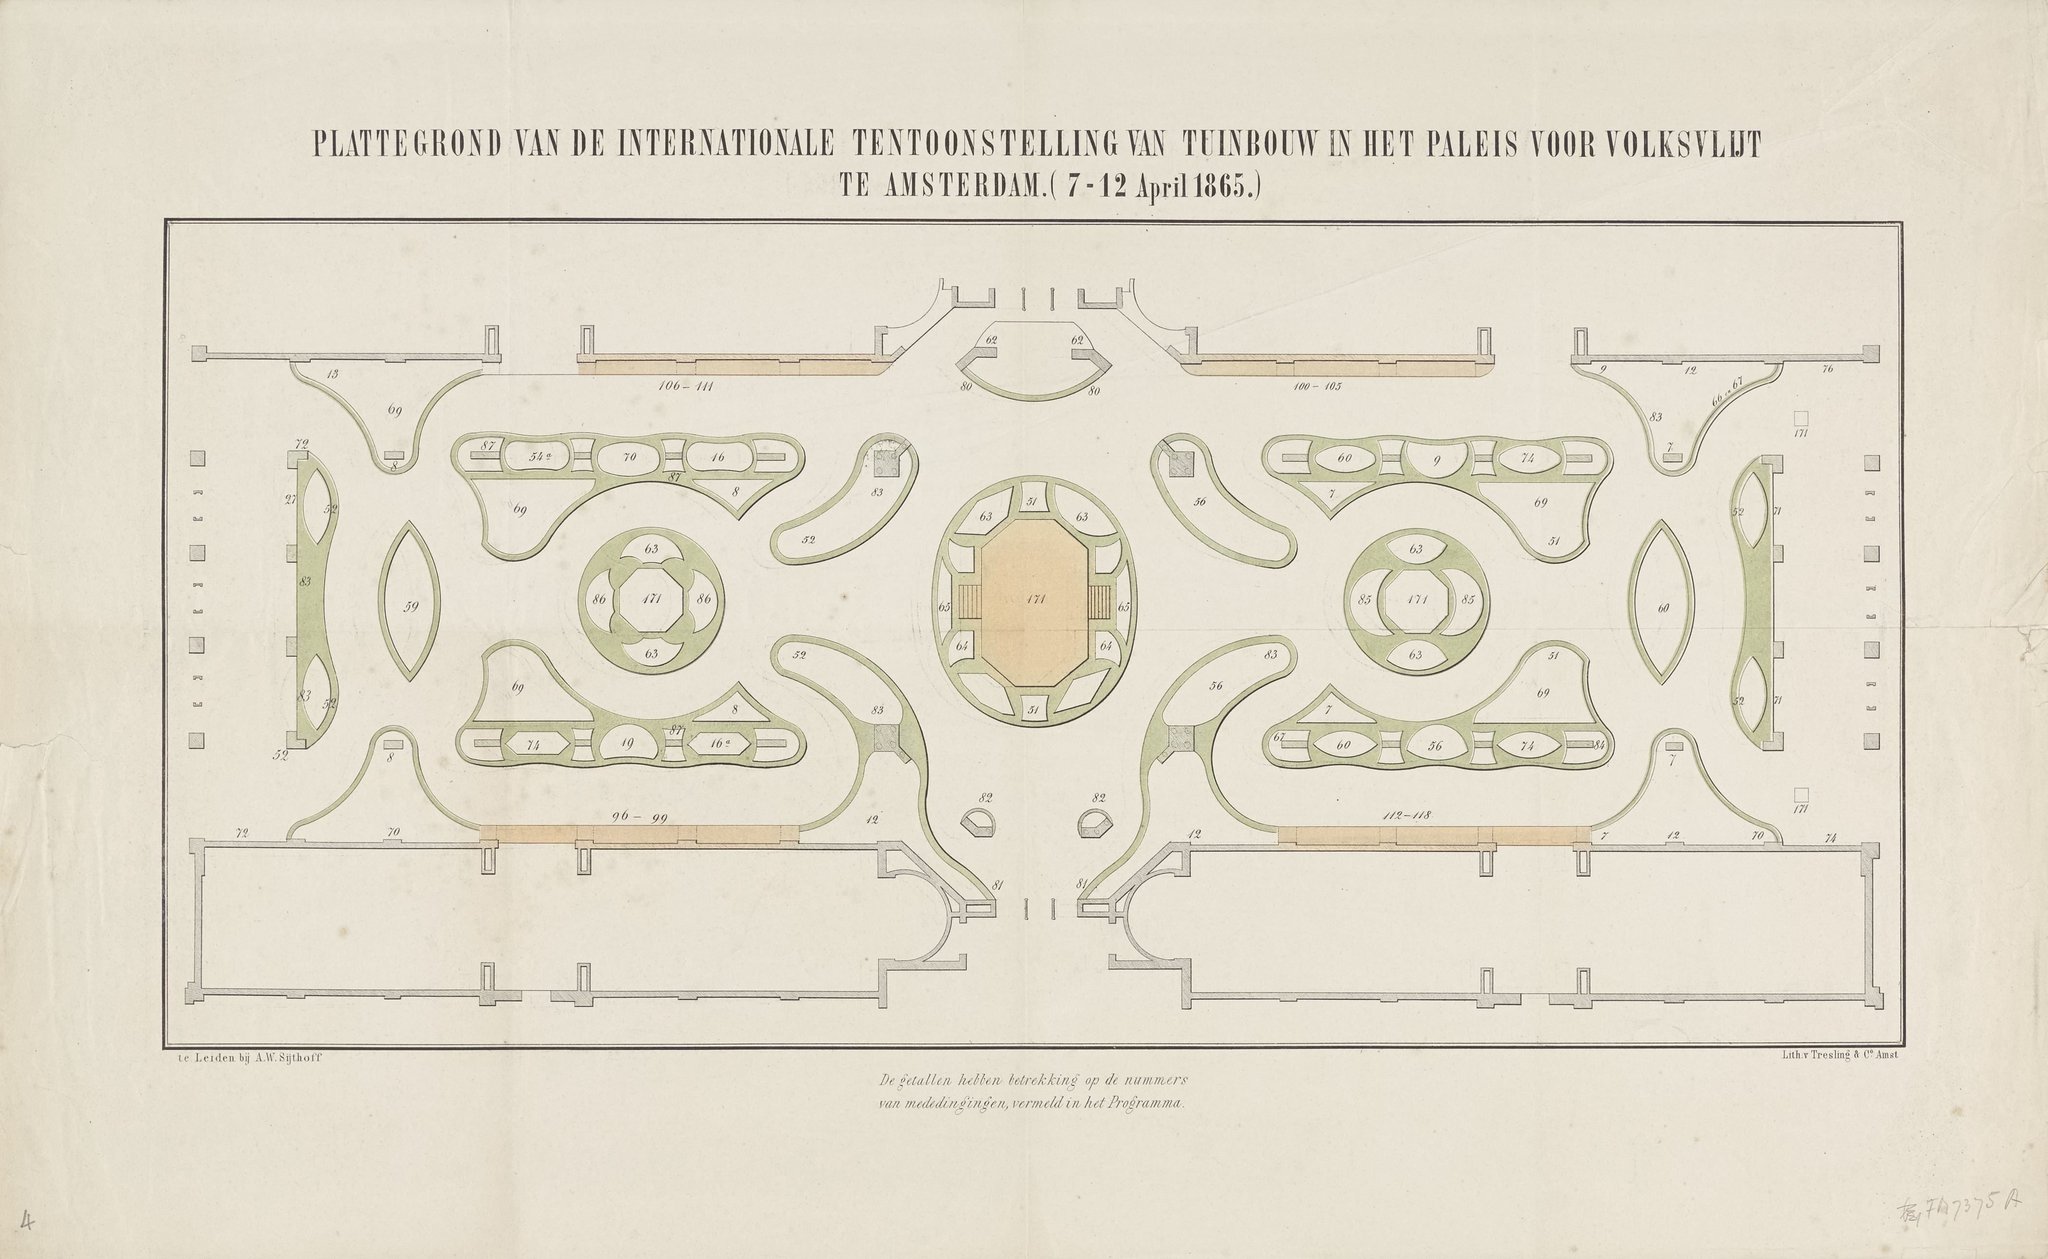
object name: print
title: Plattegrond van de Internationale Tentoonstelling van Tuinbouw in het Paleis voor Volksvlijt te Amsterdam. (7-12 April 1865.)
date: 1865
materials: paper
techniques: lithograph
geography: netherlands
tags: horticulture, vegetable culture, market gardening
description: Plattegrond van de Internationale Tentoonstelling van Tuinbouw gehouden in het Paleis voor Volksvlijt te Amsterdam, 7-12 april 1865. De verschillende onderdelen van de tentoonstelling dragen nummers die vermeld zijn in het programma.